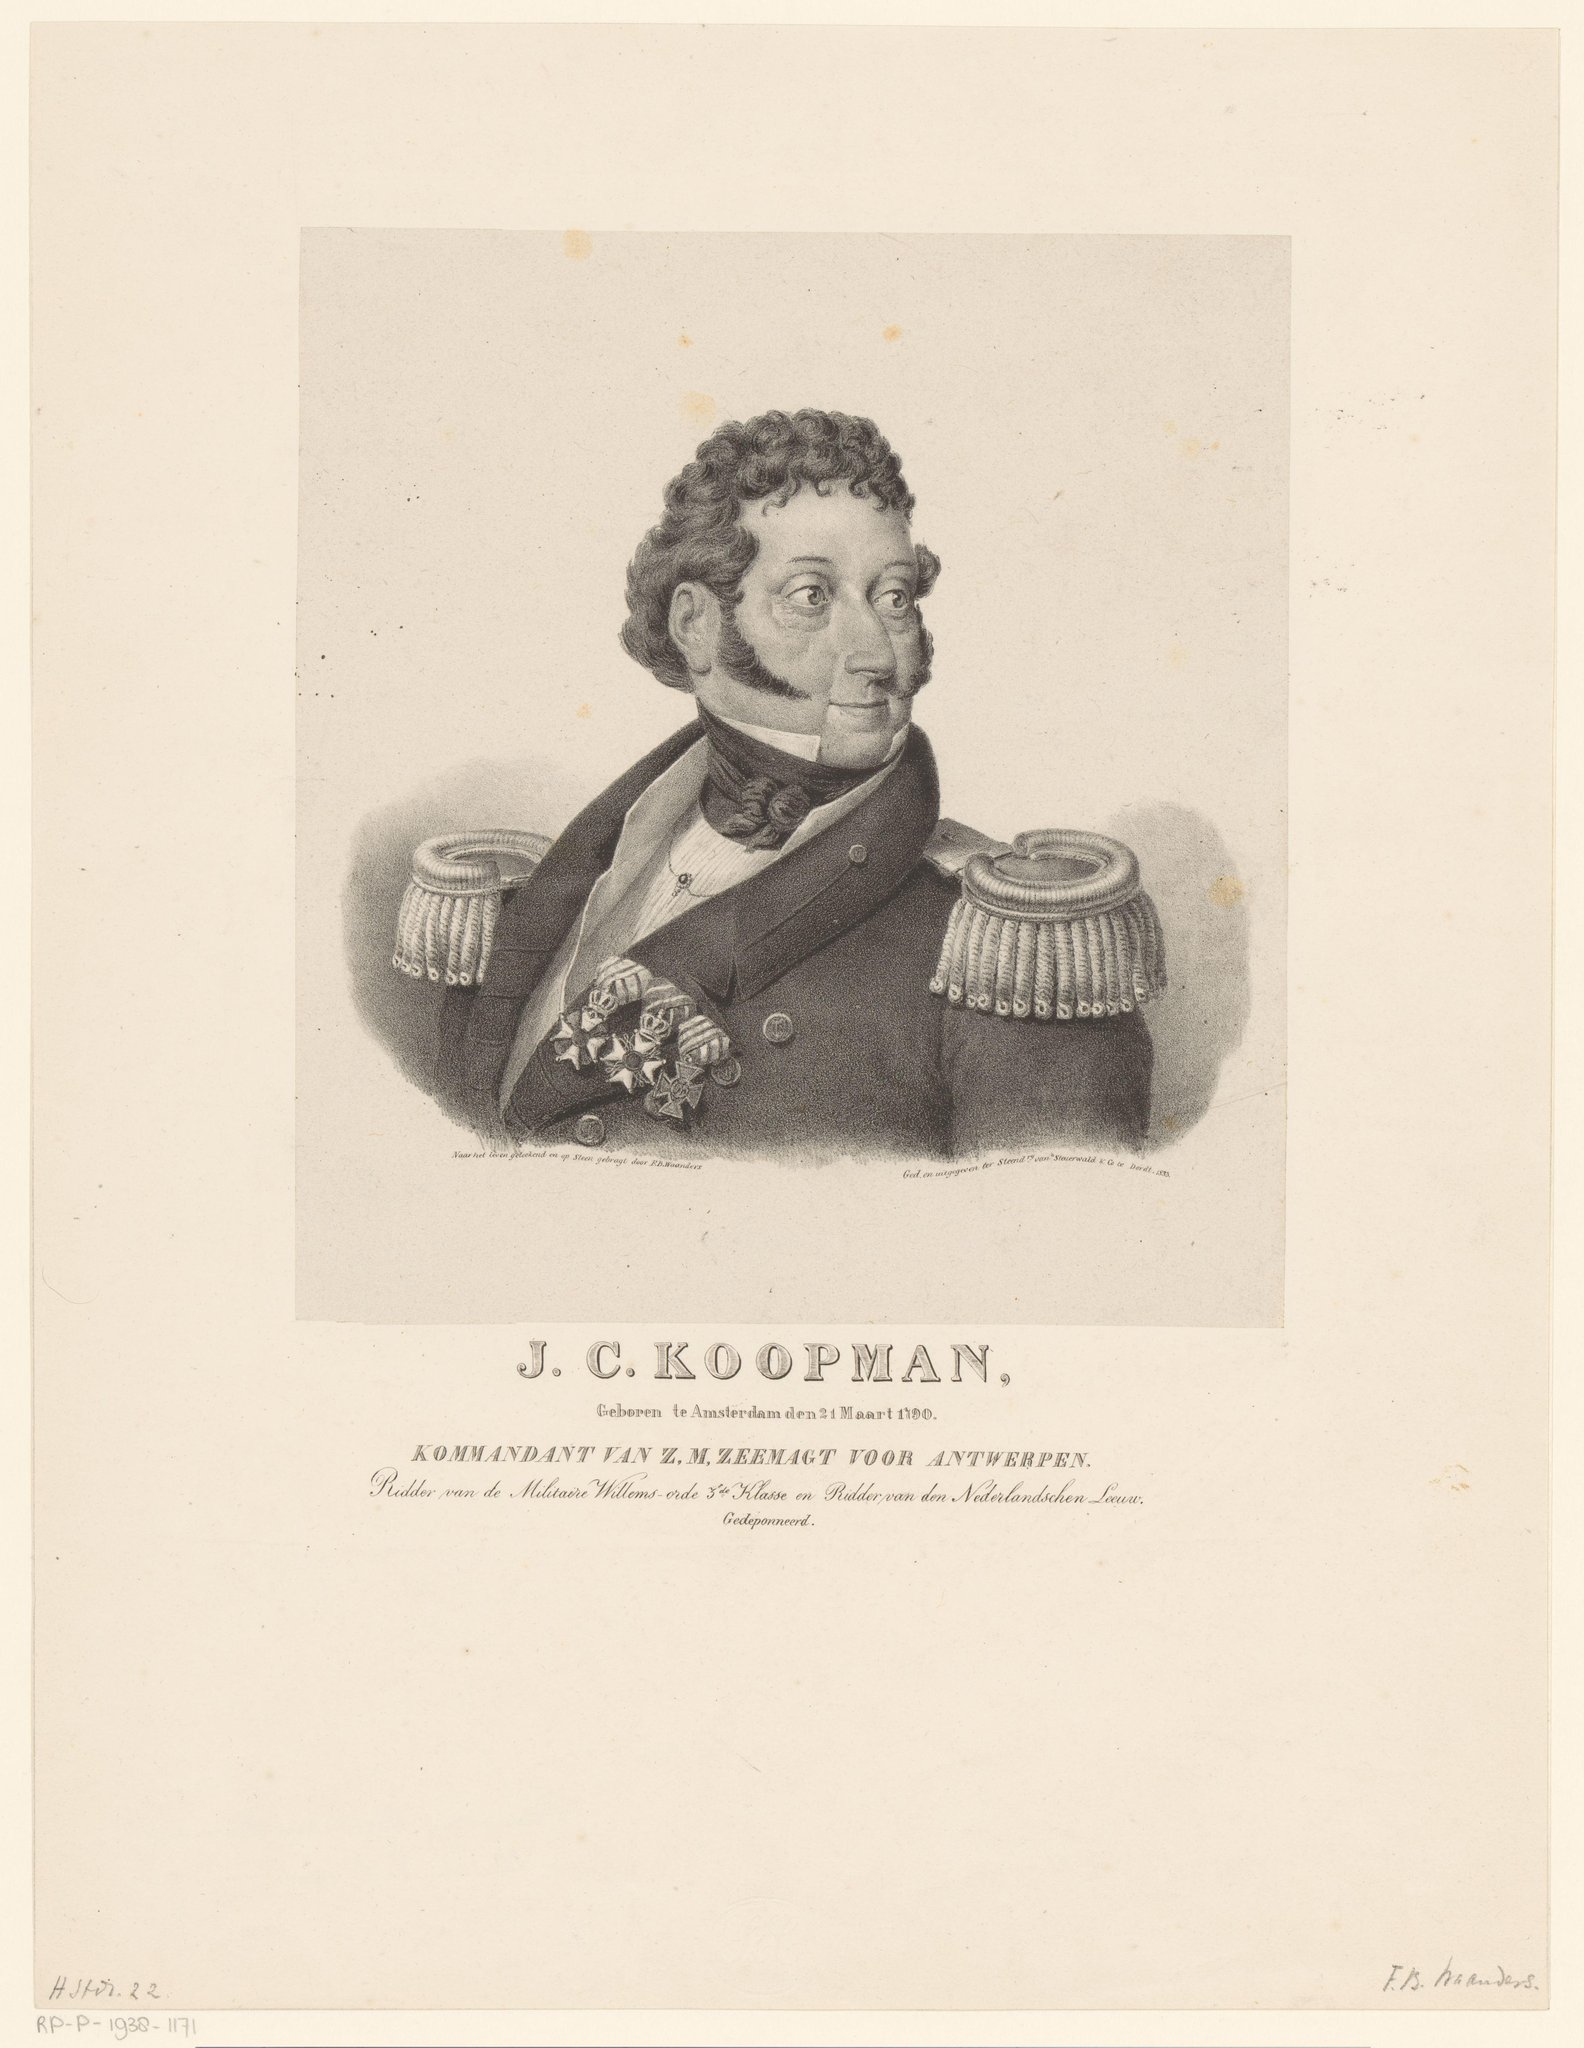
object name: print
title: Portret van Jan Coenraad Koopman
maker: franciscus bernardus waanders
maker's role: print maker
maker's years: 1809-1880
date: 1833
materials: paper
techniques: lithograph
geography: dordrecht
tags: amsterdam, utrecht, historical persons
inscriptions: check stamp: ‘S&C’, collector's mark: Lugt 2228, : ‘S&C’